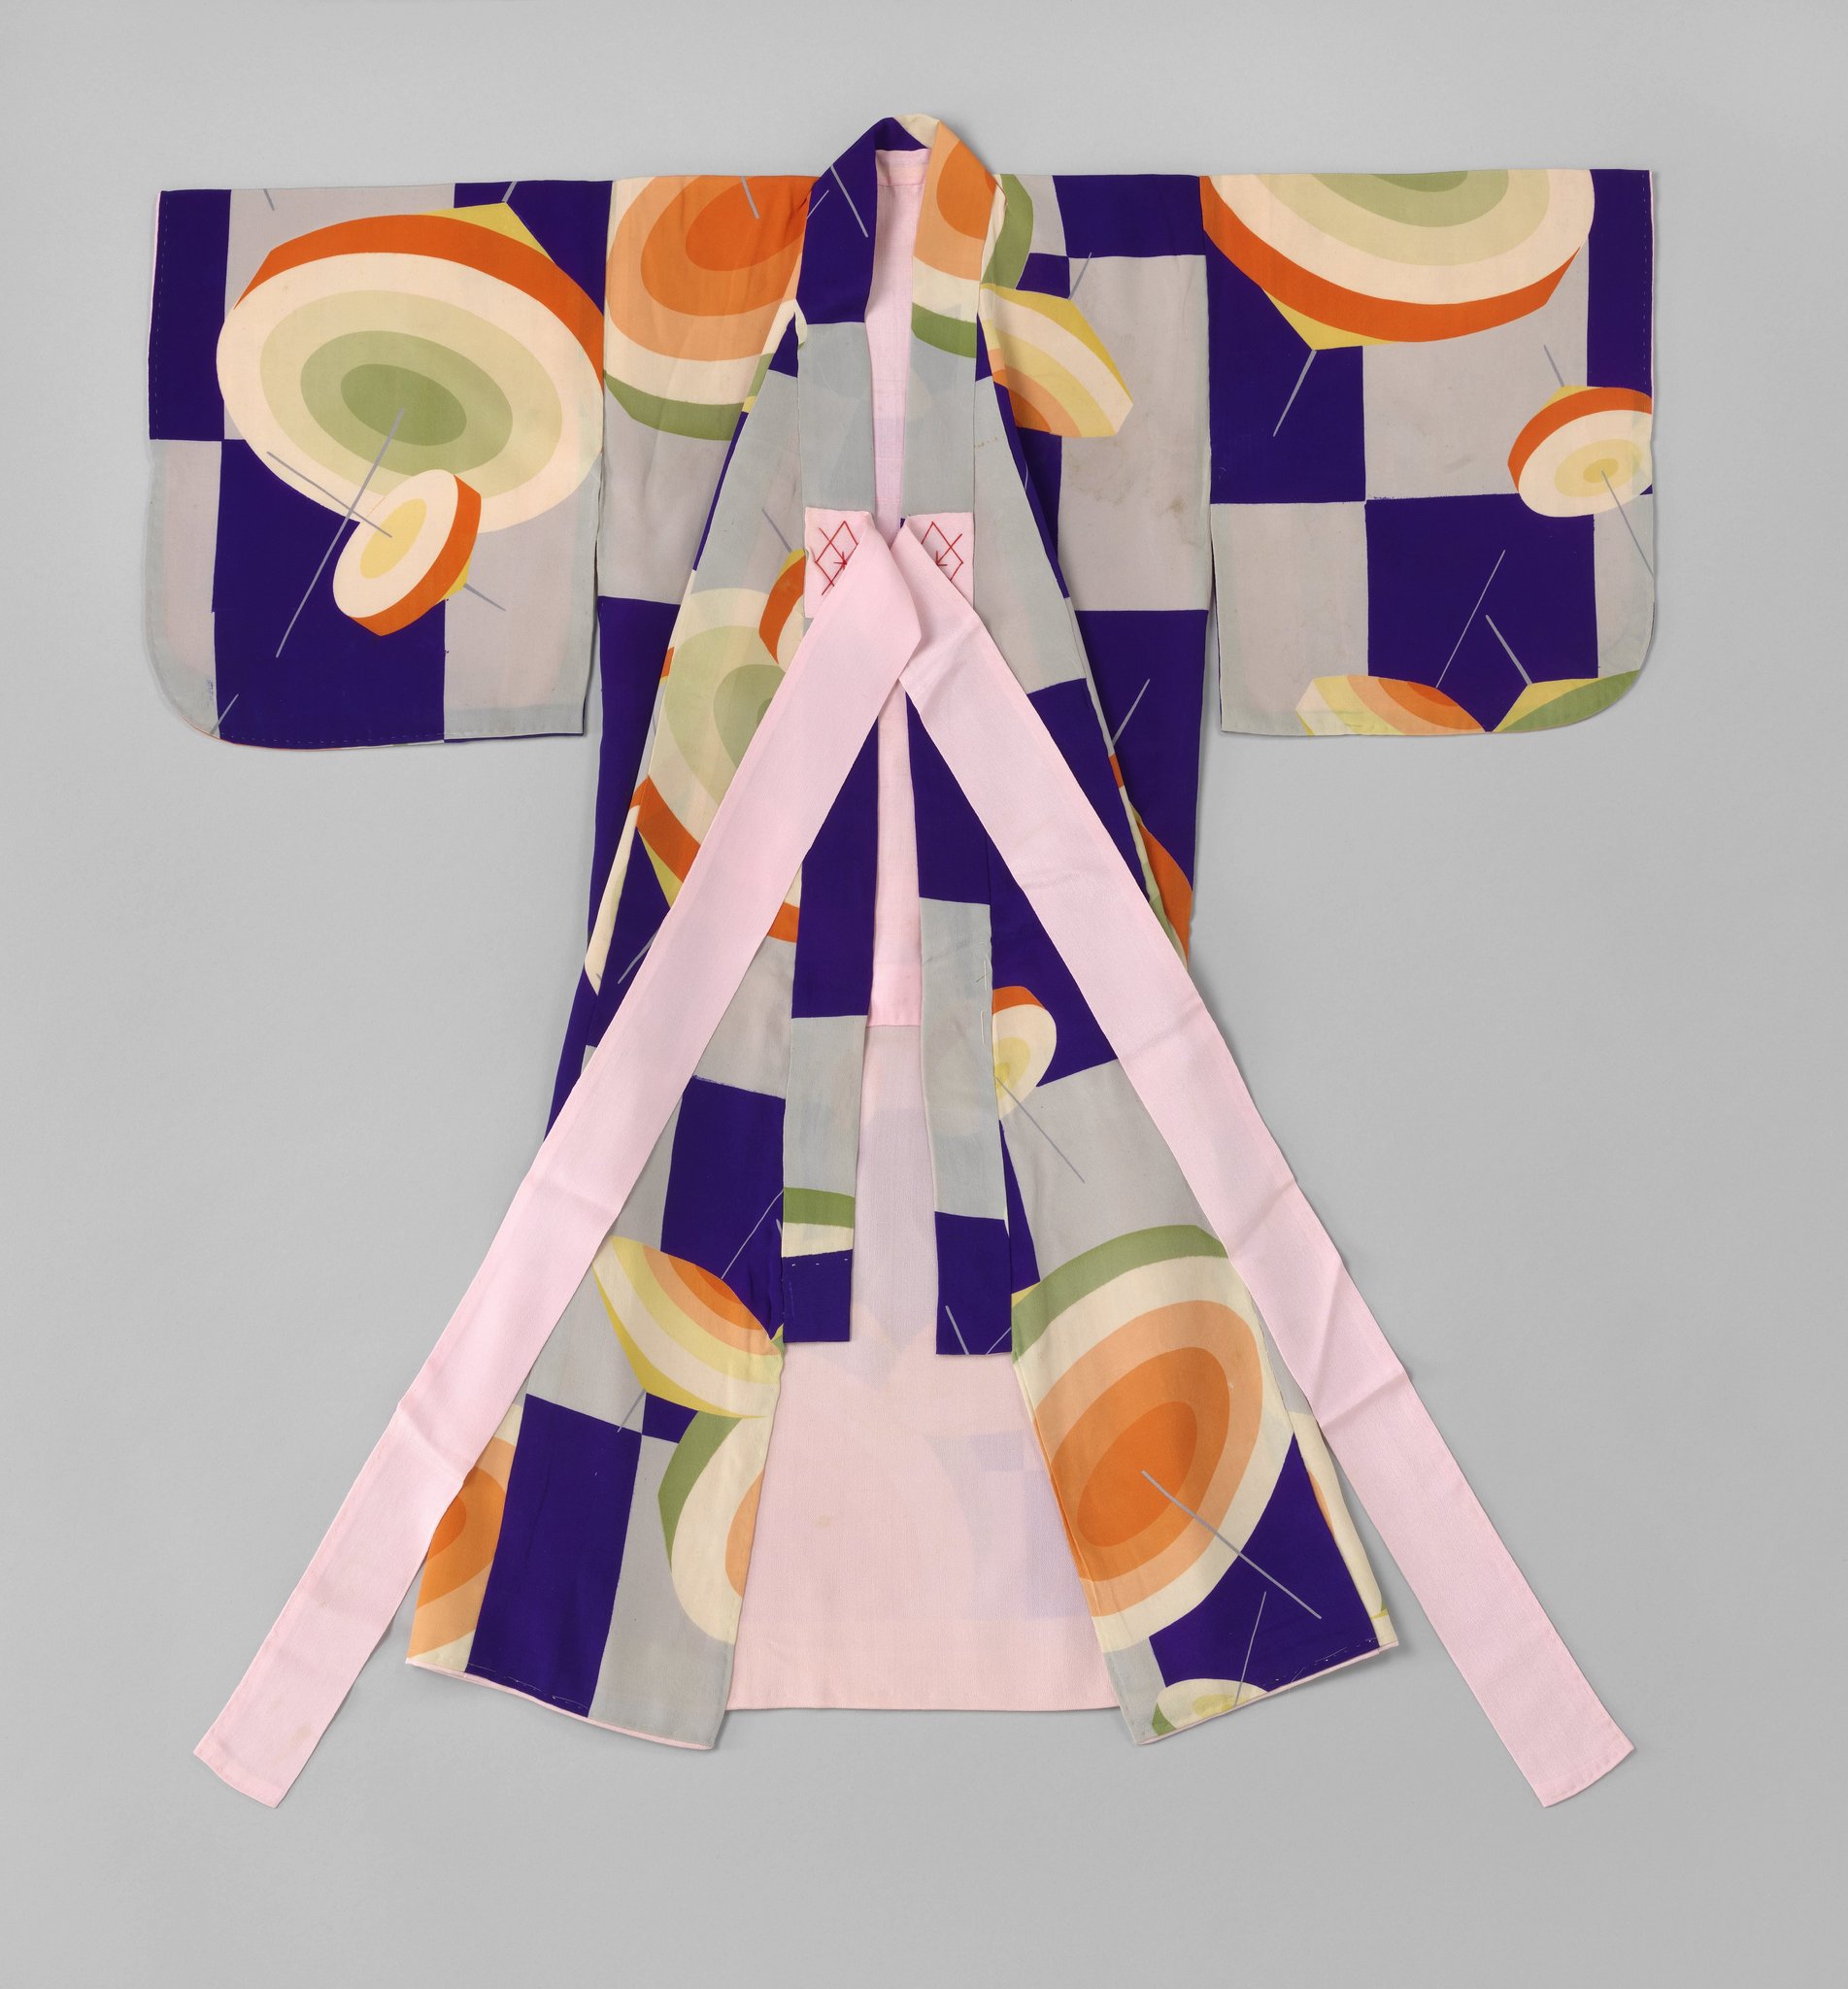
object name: kimono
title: Meisjes miyamairi kimono met tollen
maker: Anonymous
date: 1920-1940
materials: silk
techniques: painting, weave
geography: japan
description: Formele kimono voor een meisje voor het eerste bezoek aan een Shinto schrijn (miyamairi kimono), met een versiering van tollen van verschillende maten tegen een donker- en lichblauw geblokte achtergrond. Blauwe crepe zijde (chirimen) met een gestencilde yuzen decoratie in blauw, geel en verschillende tinten groen en oranje. Voering van roze crepe zijde (chirimen).